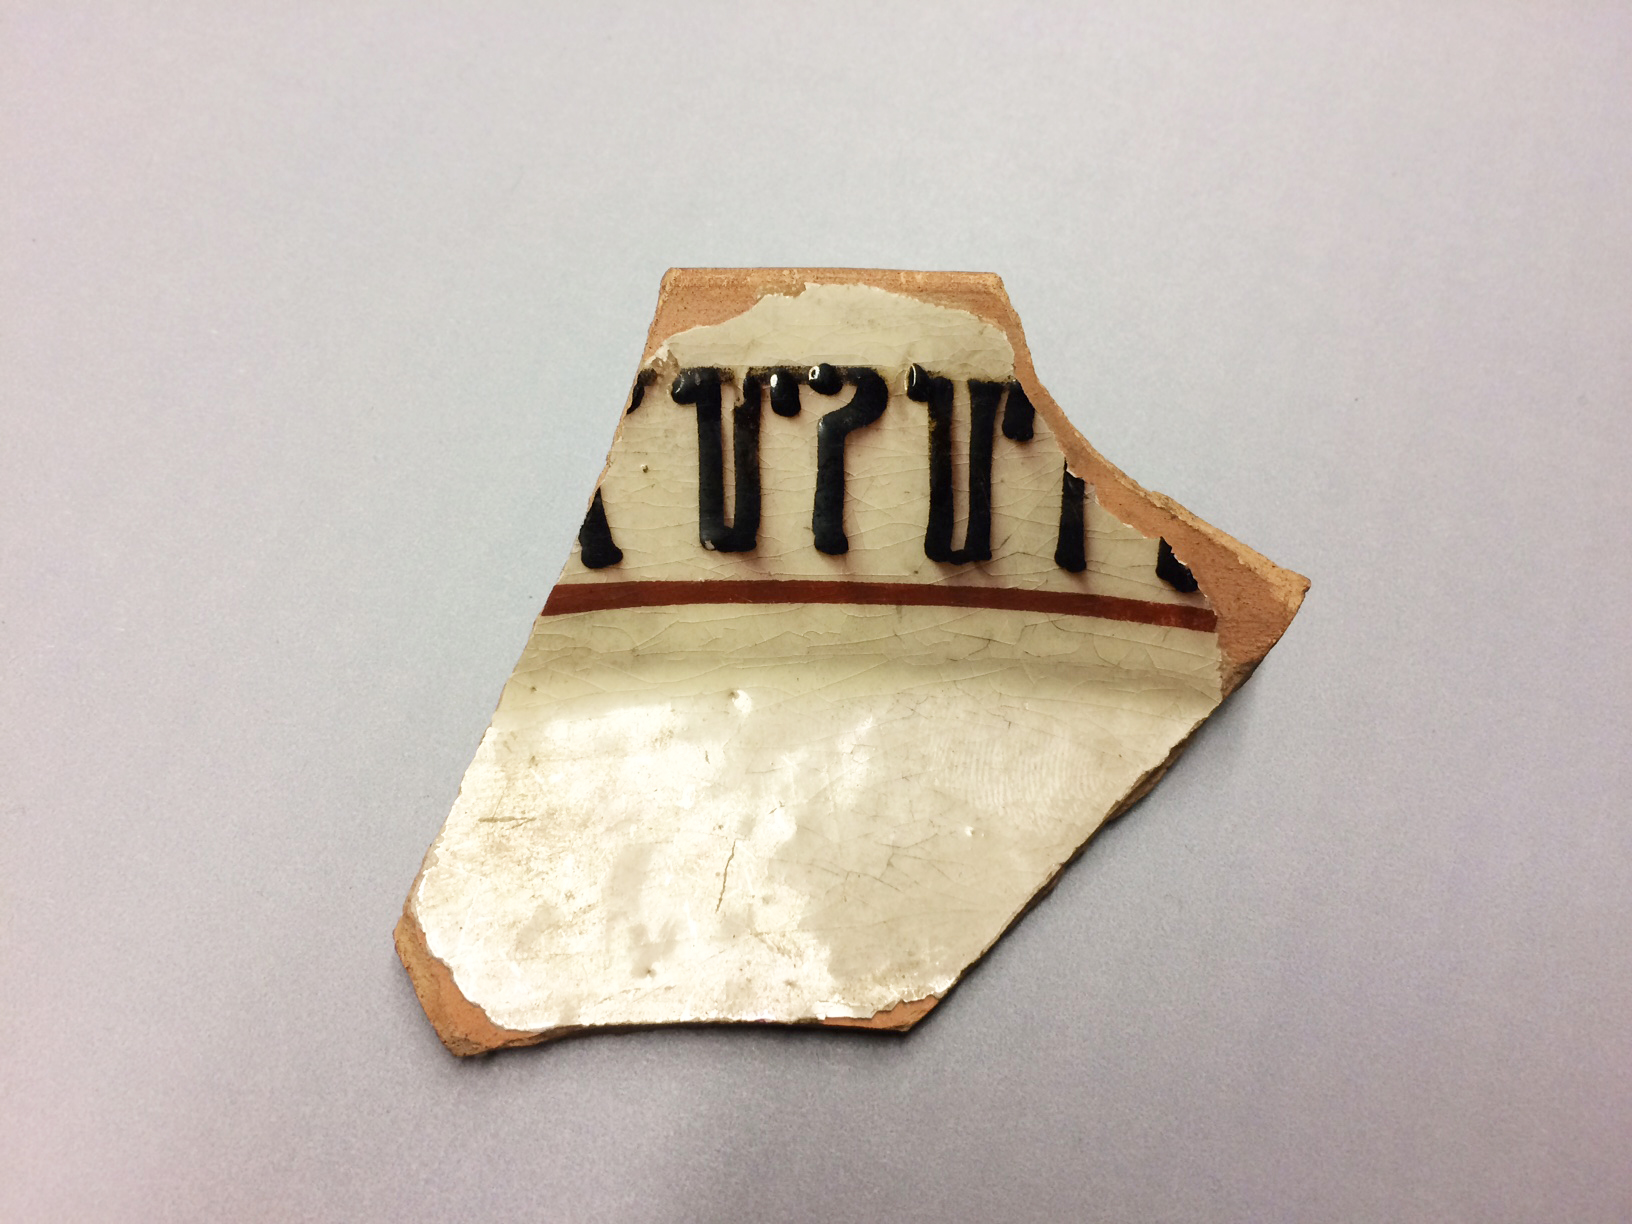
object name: fragment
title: Ceramic Fragment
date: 801-1000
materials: earthenware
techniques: glazing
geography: iran